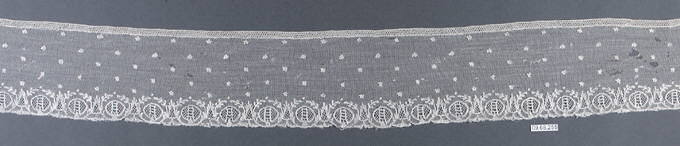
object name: border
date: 1767-1800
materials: lace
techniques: lace